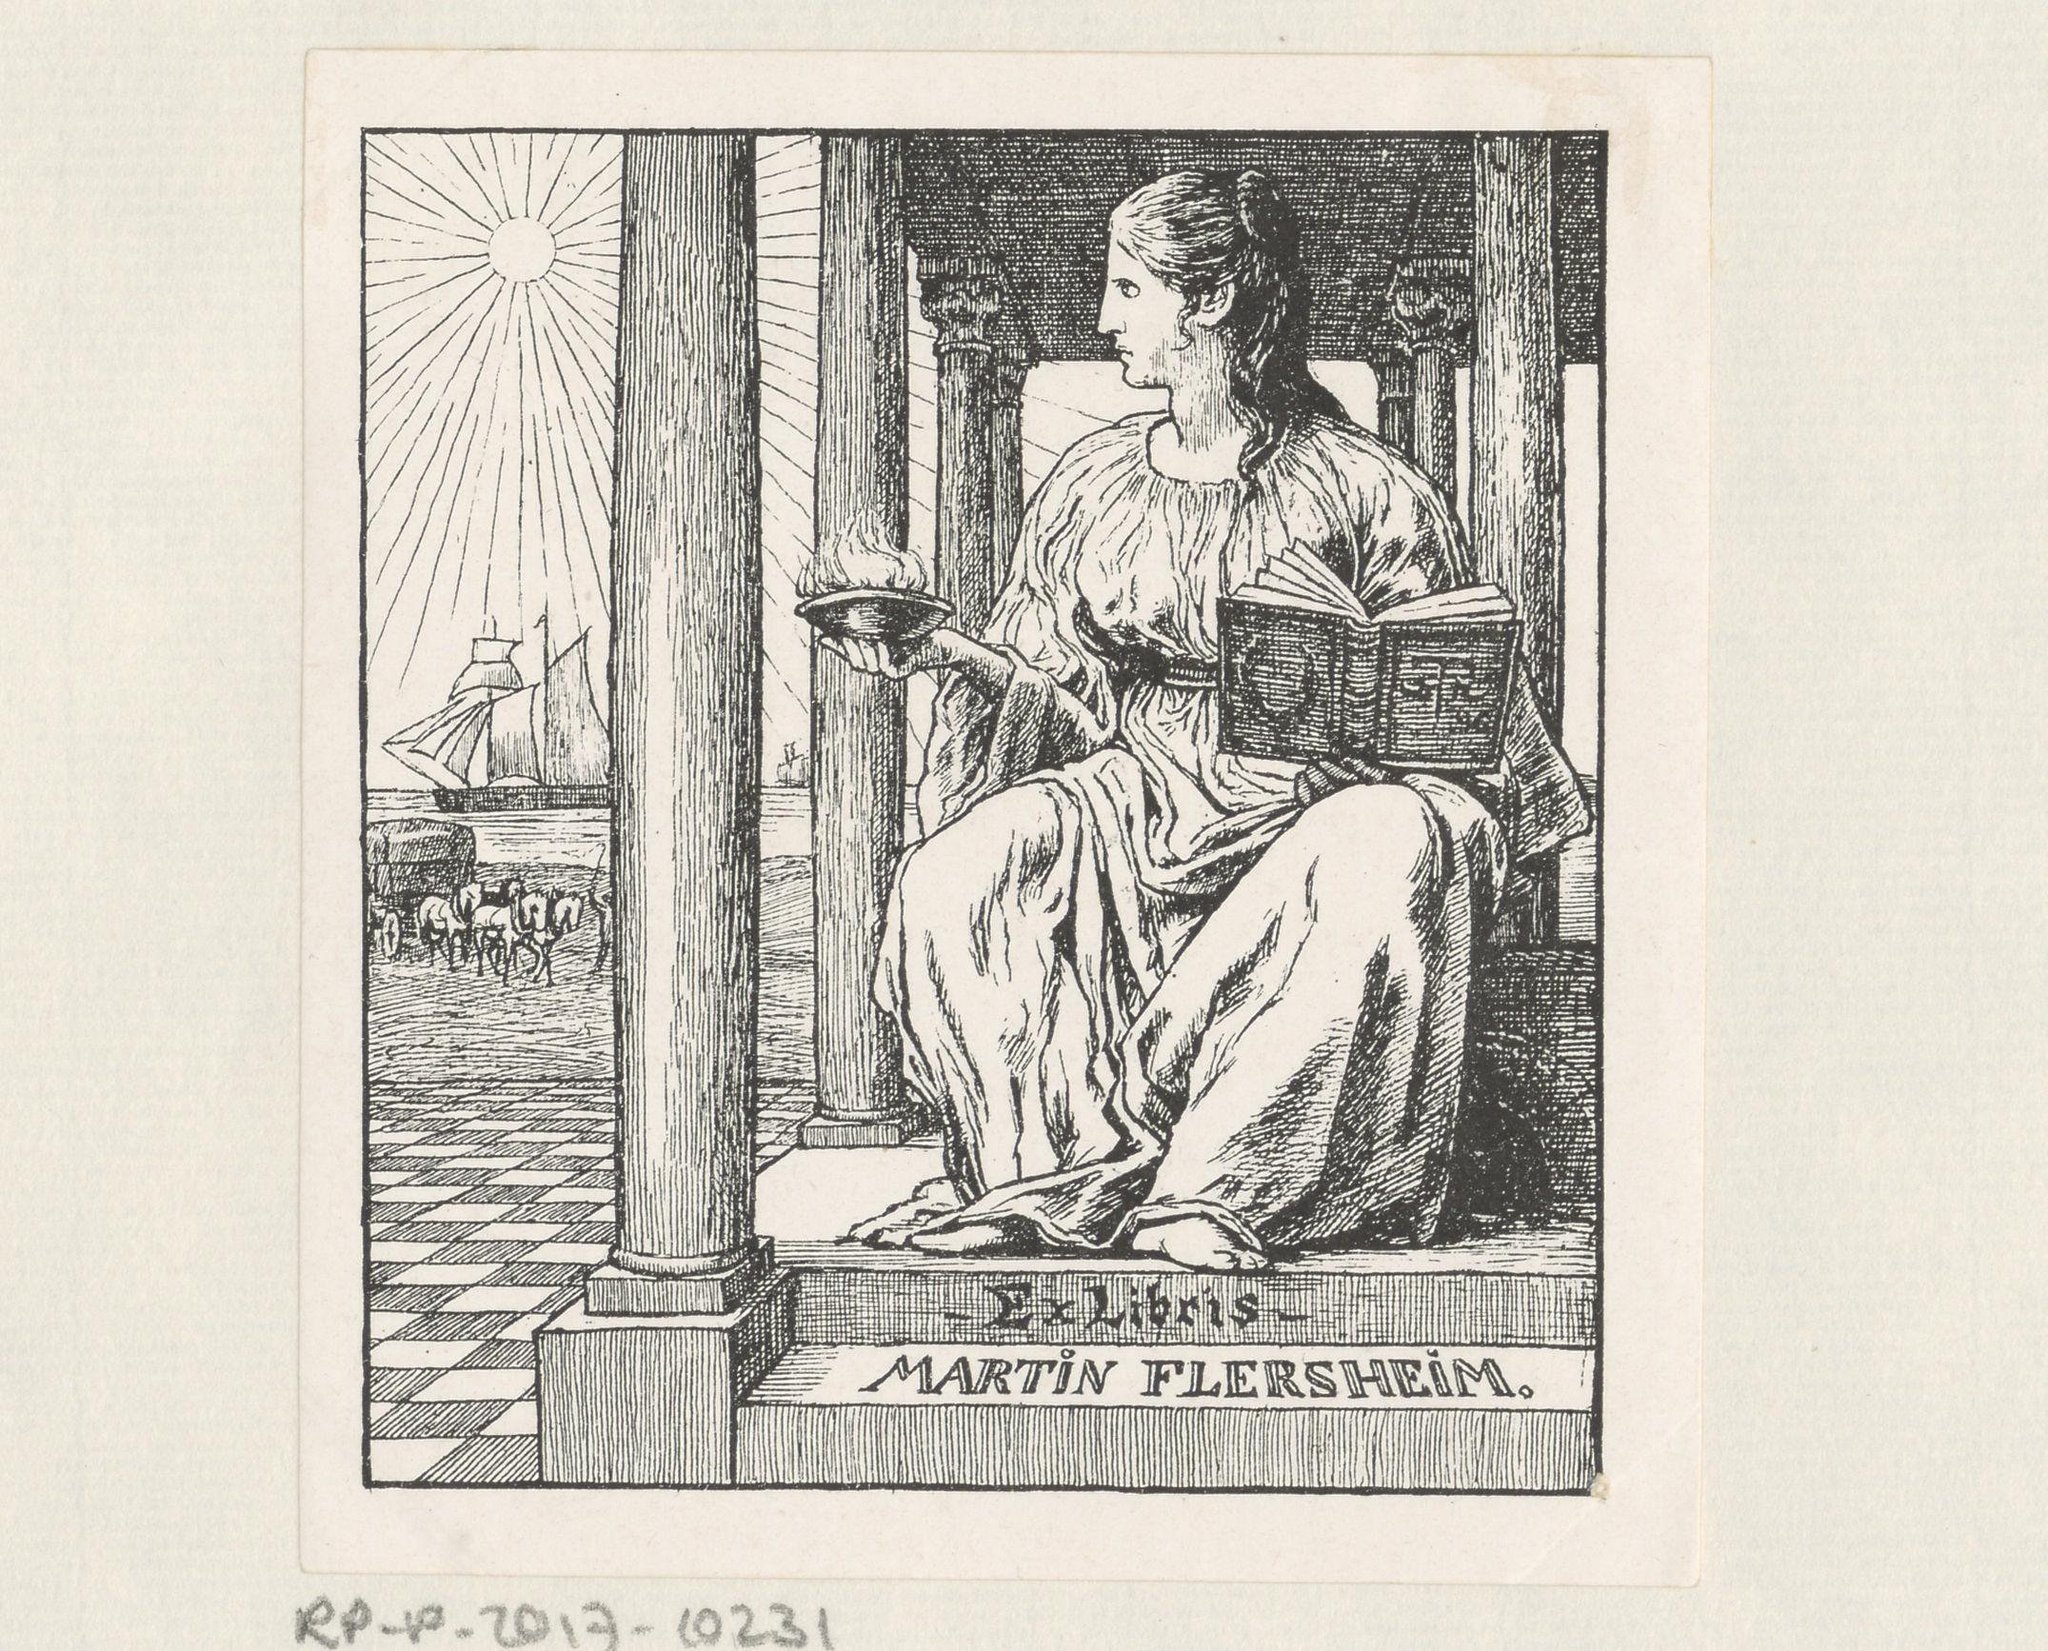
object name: bookplate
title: Ex libris van Martin Flersheim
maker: hans thoma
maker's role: painter, print maker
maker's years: 1839-1924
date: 1896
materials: paper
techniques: lithograph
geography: germany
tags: sailing-ship, sailing-boat, sitting figure - aa - female human figure, book, temple, shrine ~ greek religion